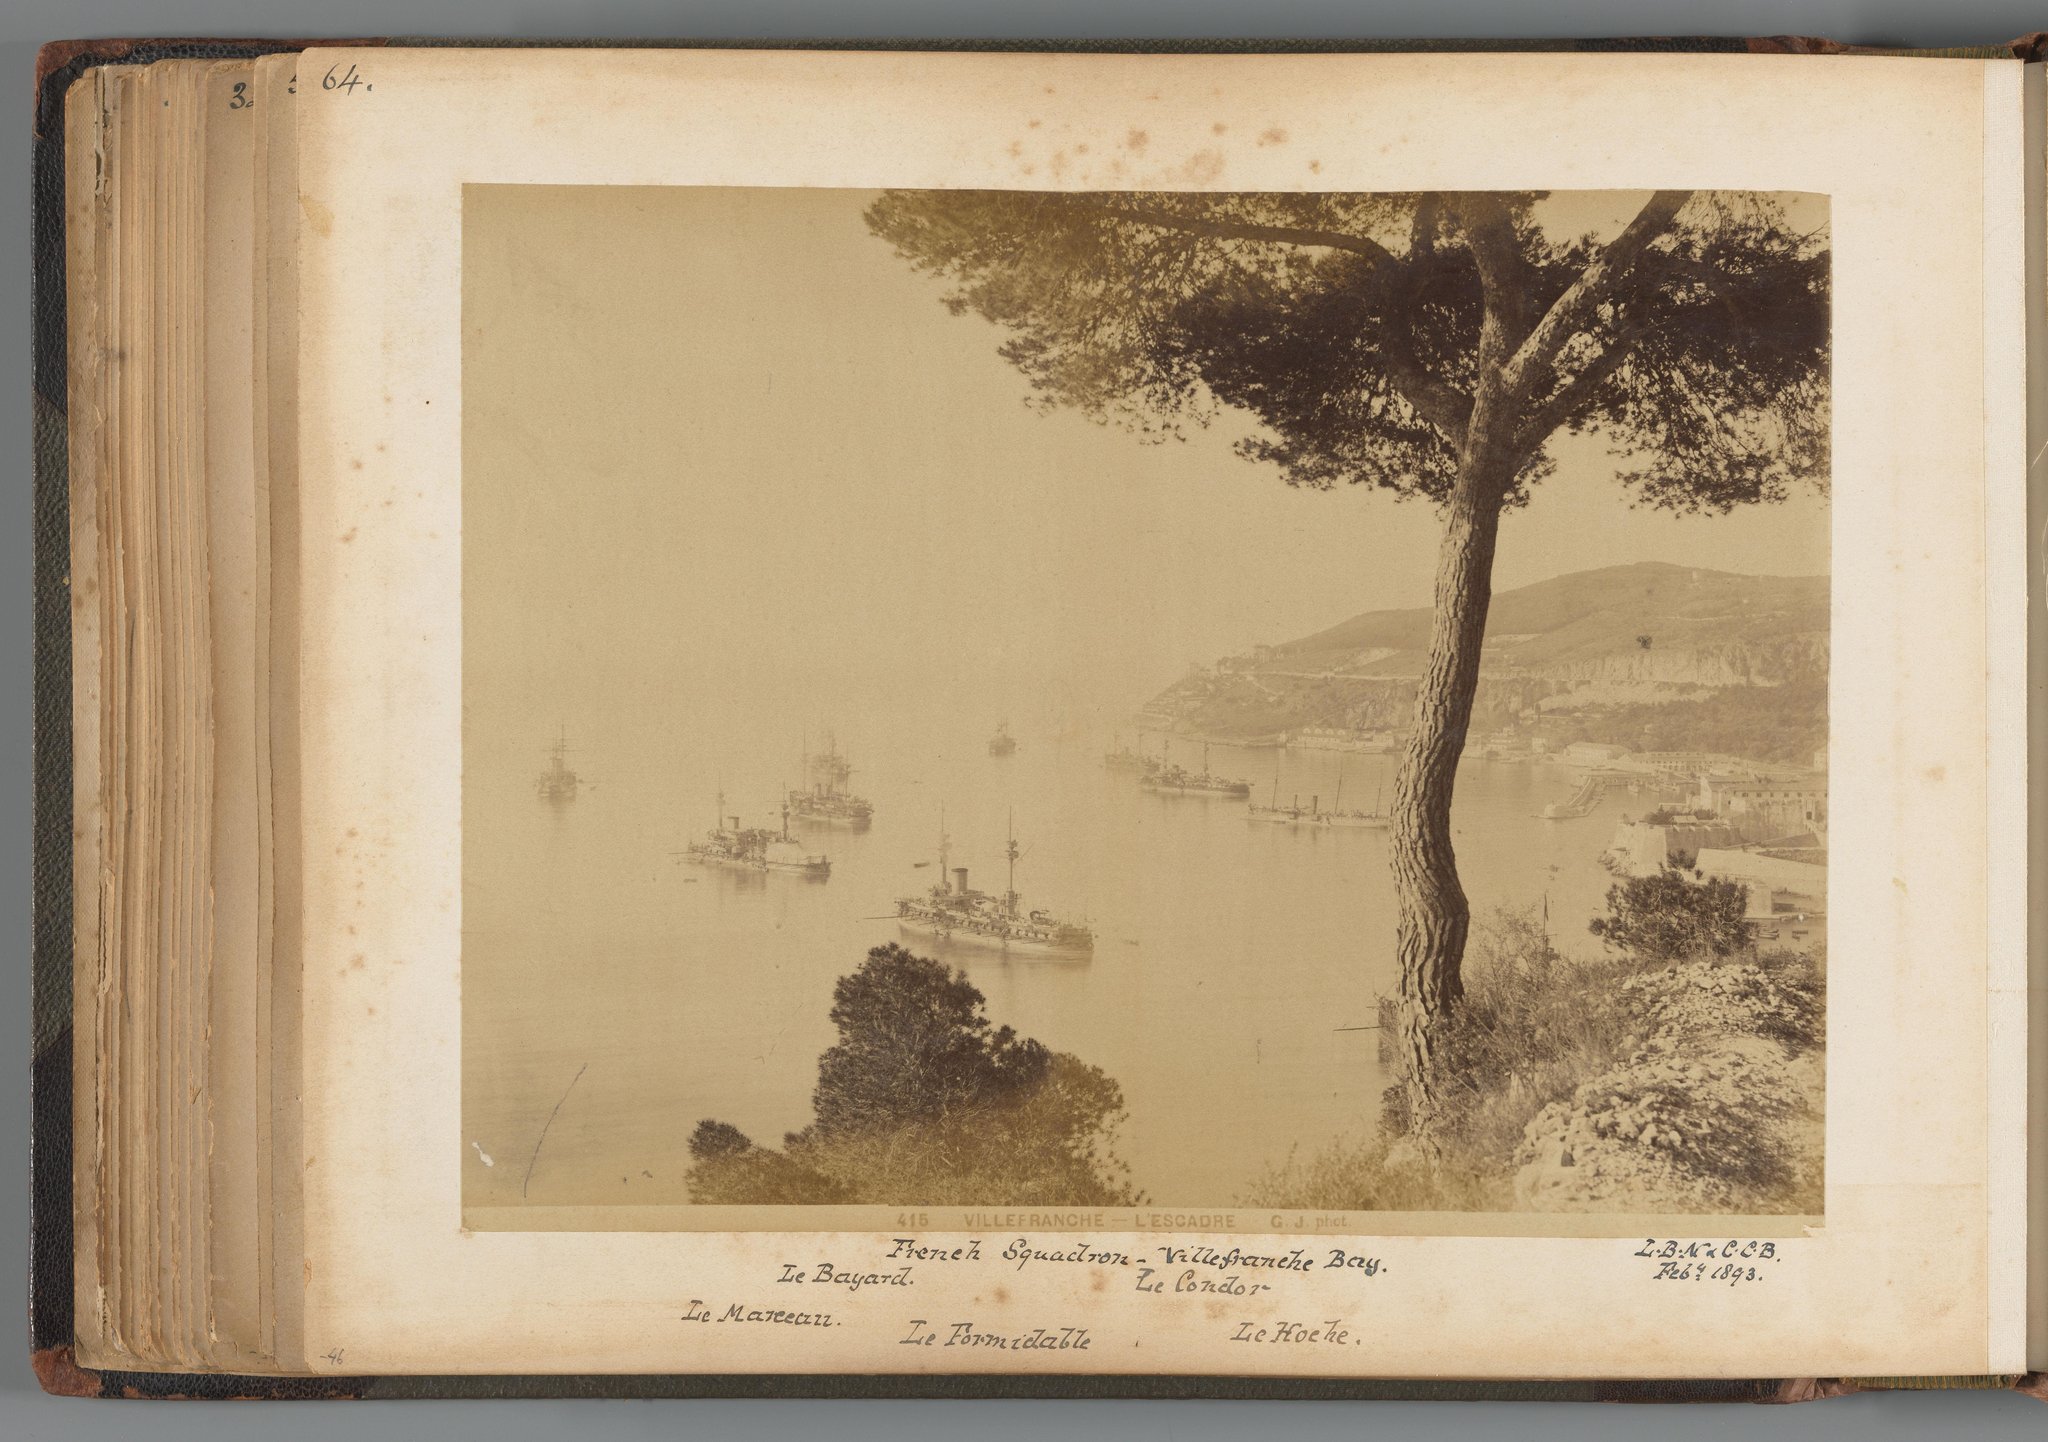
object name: album leaf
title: Marineschepen aan de kust van Villefranche-sur-Mer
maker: jean gilletta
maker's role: fotograaf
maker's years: 1856-1933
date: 1802-1893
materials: paper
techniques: albumen print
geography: villefranche-sur-mer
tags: gulf, bay, ships (in general)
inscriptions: number: ‘415’, inscription: ‘Le Bayard/ Le Condor/ Le Marceau/ Le Formidable/ Le Hoeke/ L.B.N. & C.C.B.’